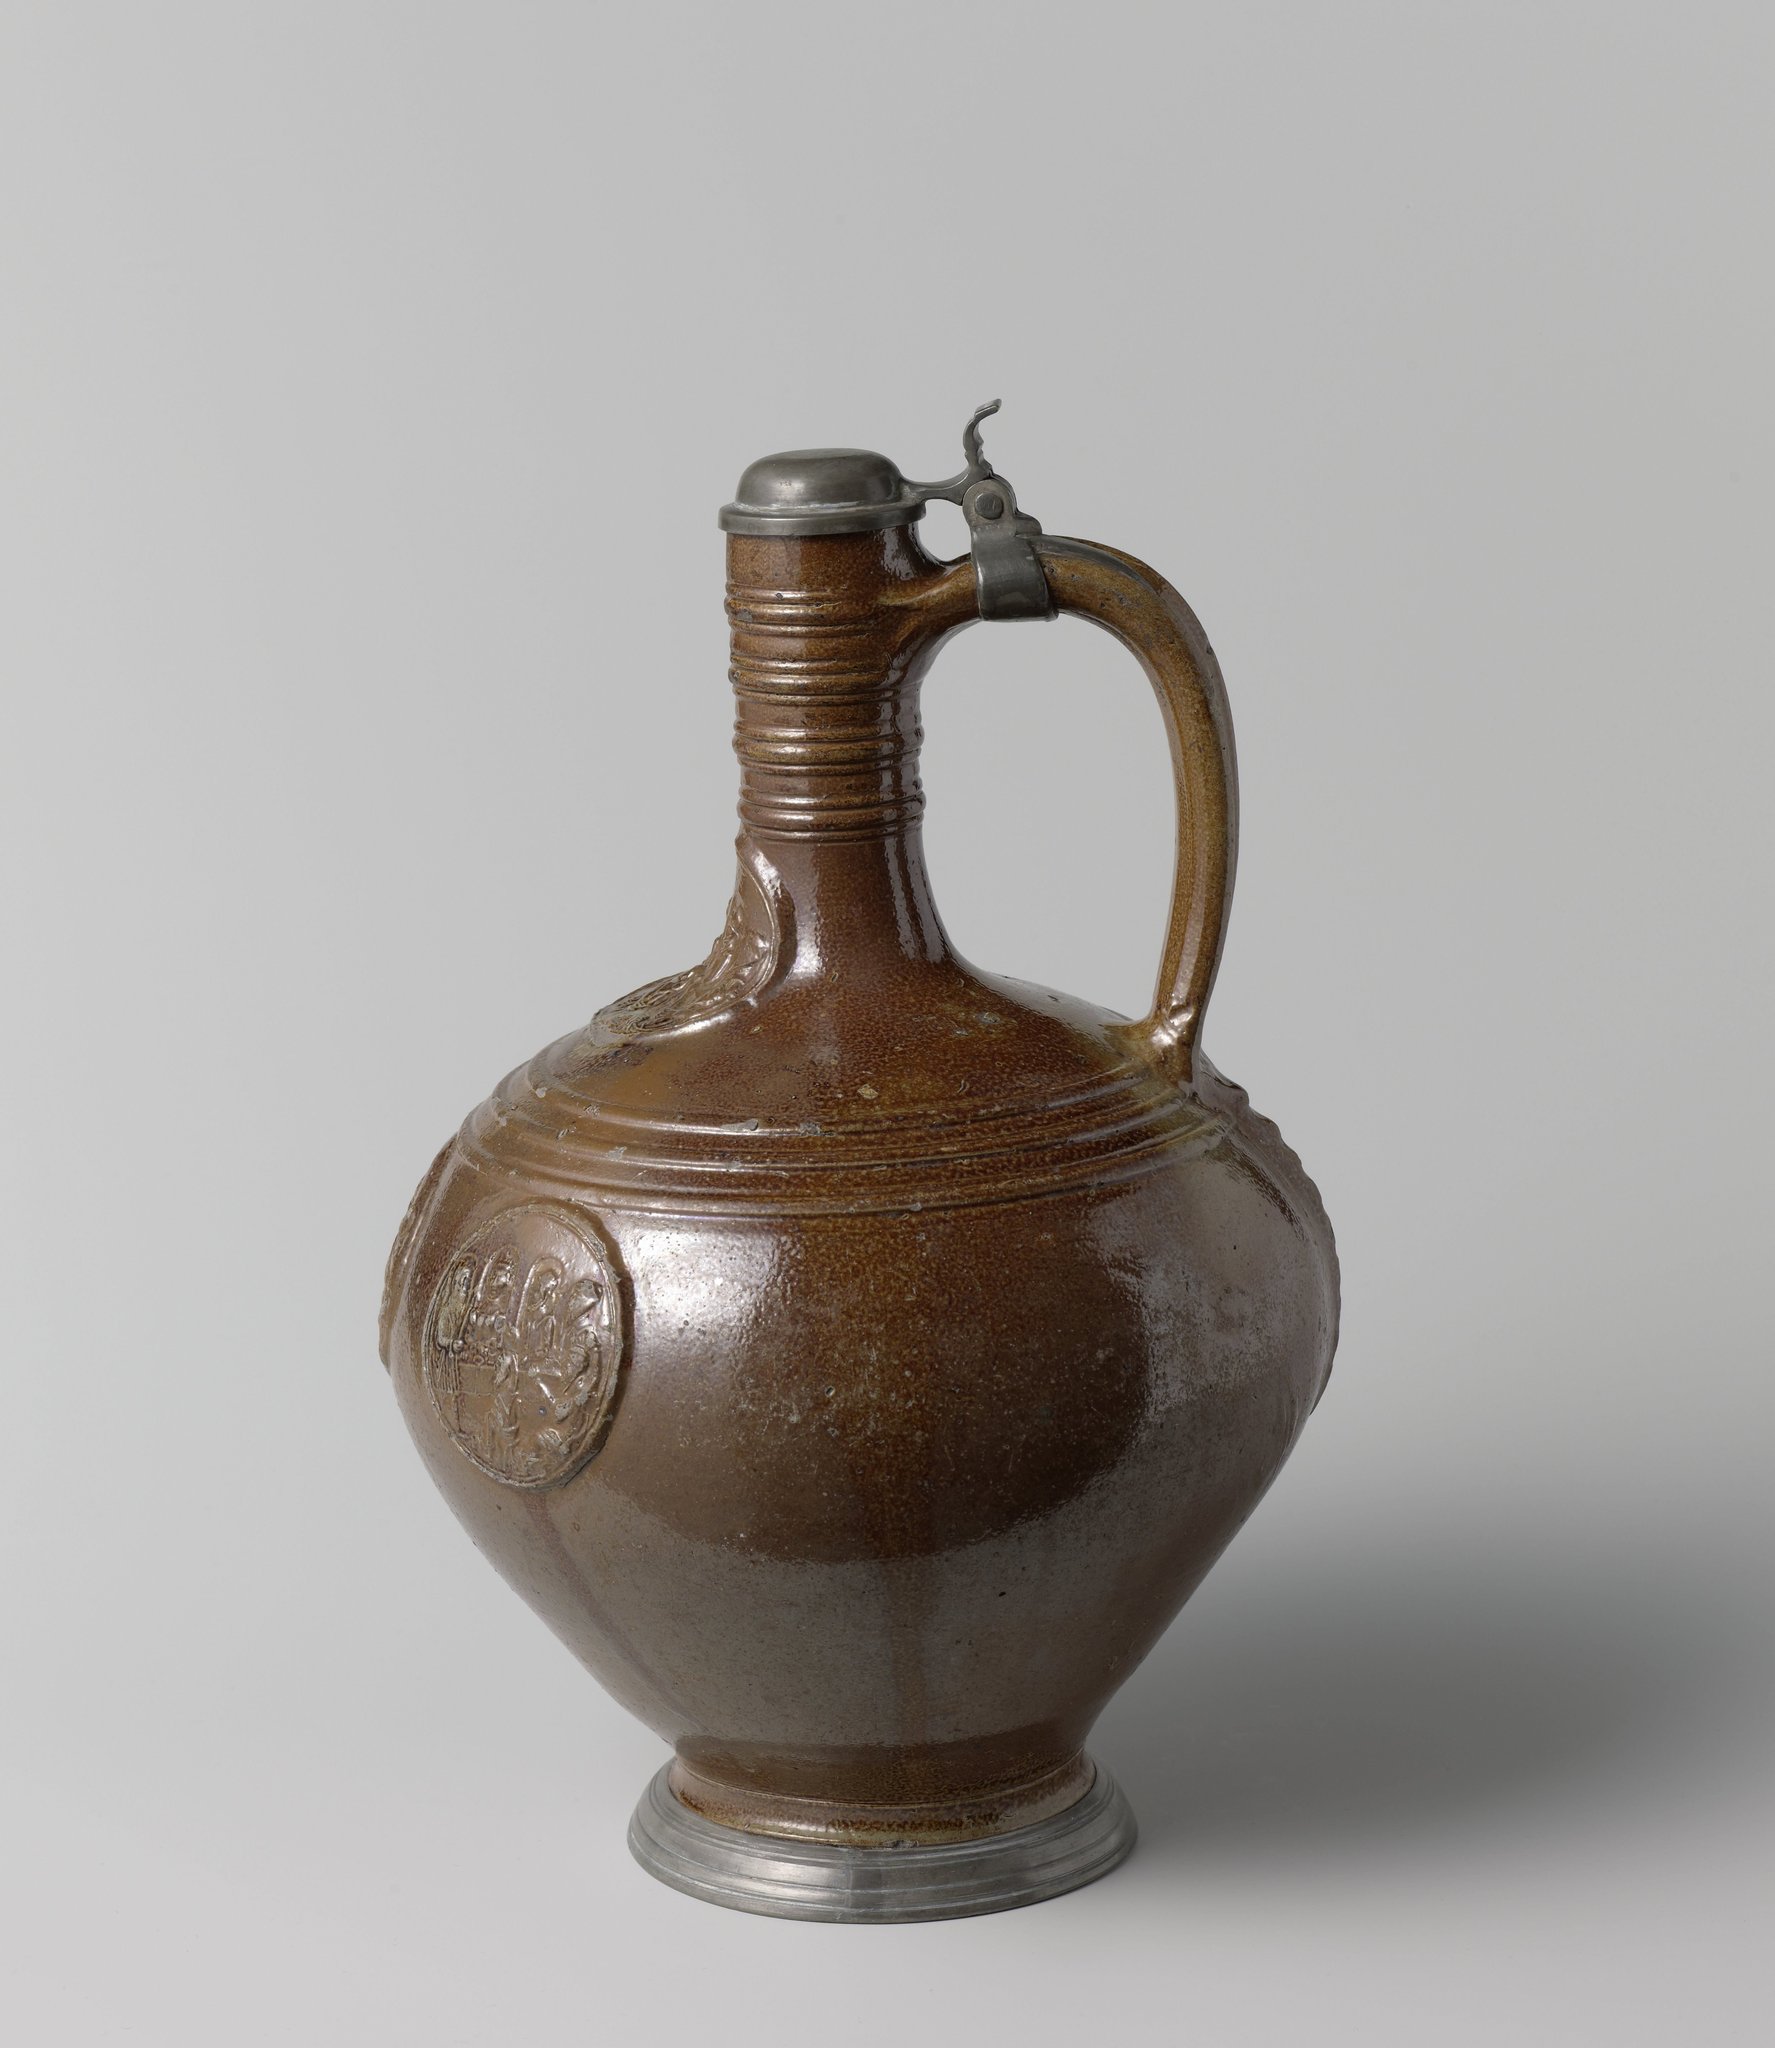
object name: jug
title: Jug with the Feast of Herod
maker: Anonymous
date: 1570-1575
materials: engobe, glaze, stoneware, tin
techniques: firing, forming, relief, vitrification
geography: raeren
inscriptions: signature: ‘PK’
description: Kruik van steengoed op hoge voet met een eivormig lichaam en smalle, lange nek. Het oor is bevestigd aan de nek en de schouder. Profielen op de nek, schouder en voet. Bedekt met een bruine engobe. Op de buik en nek in reliëf vier gedrukte en opgelegde medaillons met het Feest van Herodes. Bevestigd aan het oor een tinnen montuur met deksel en ook de voet is gevat in een tinnen montuur. Raeren.